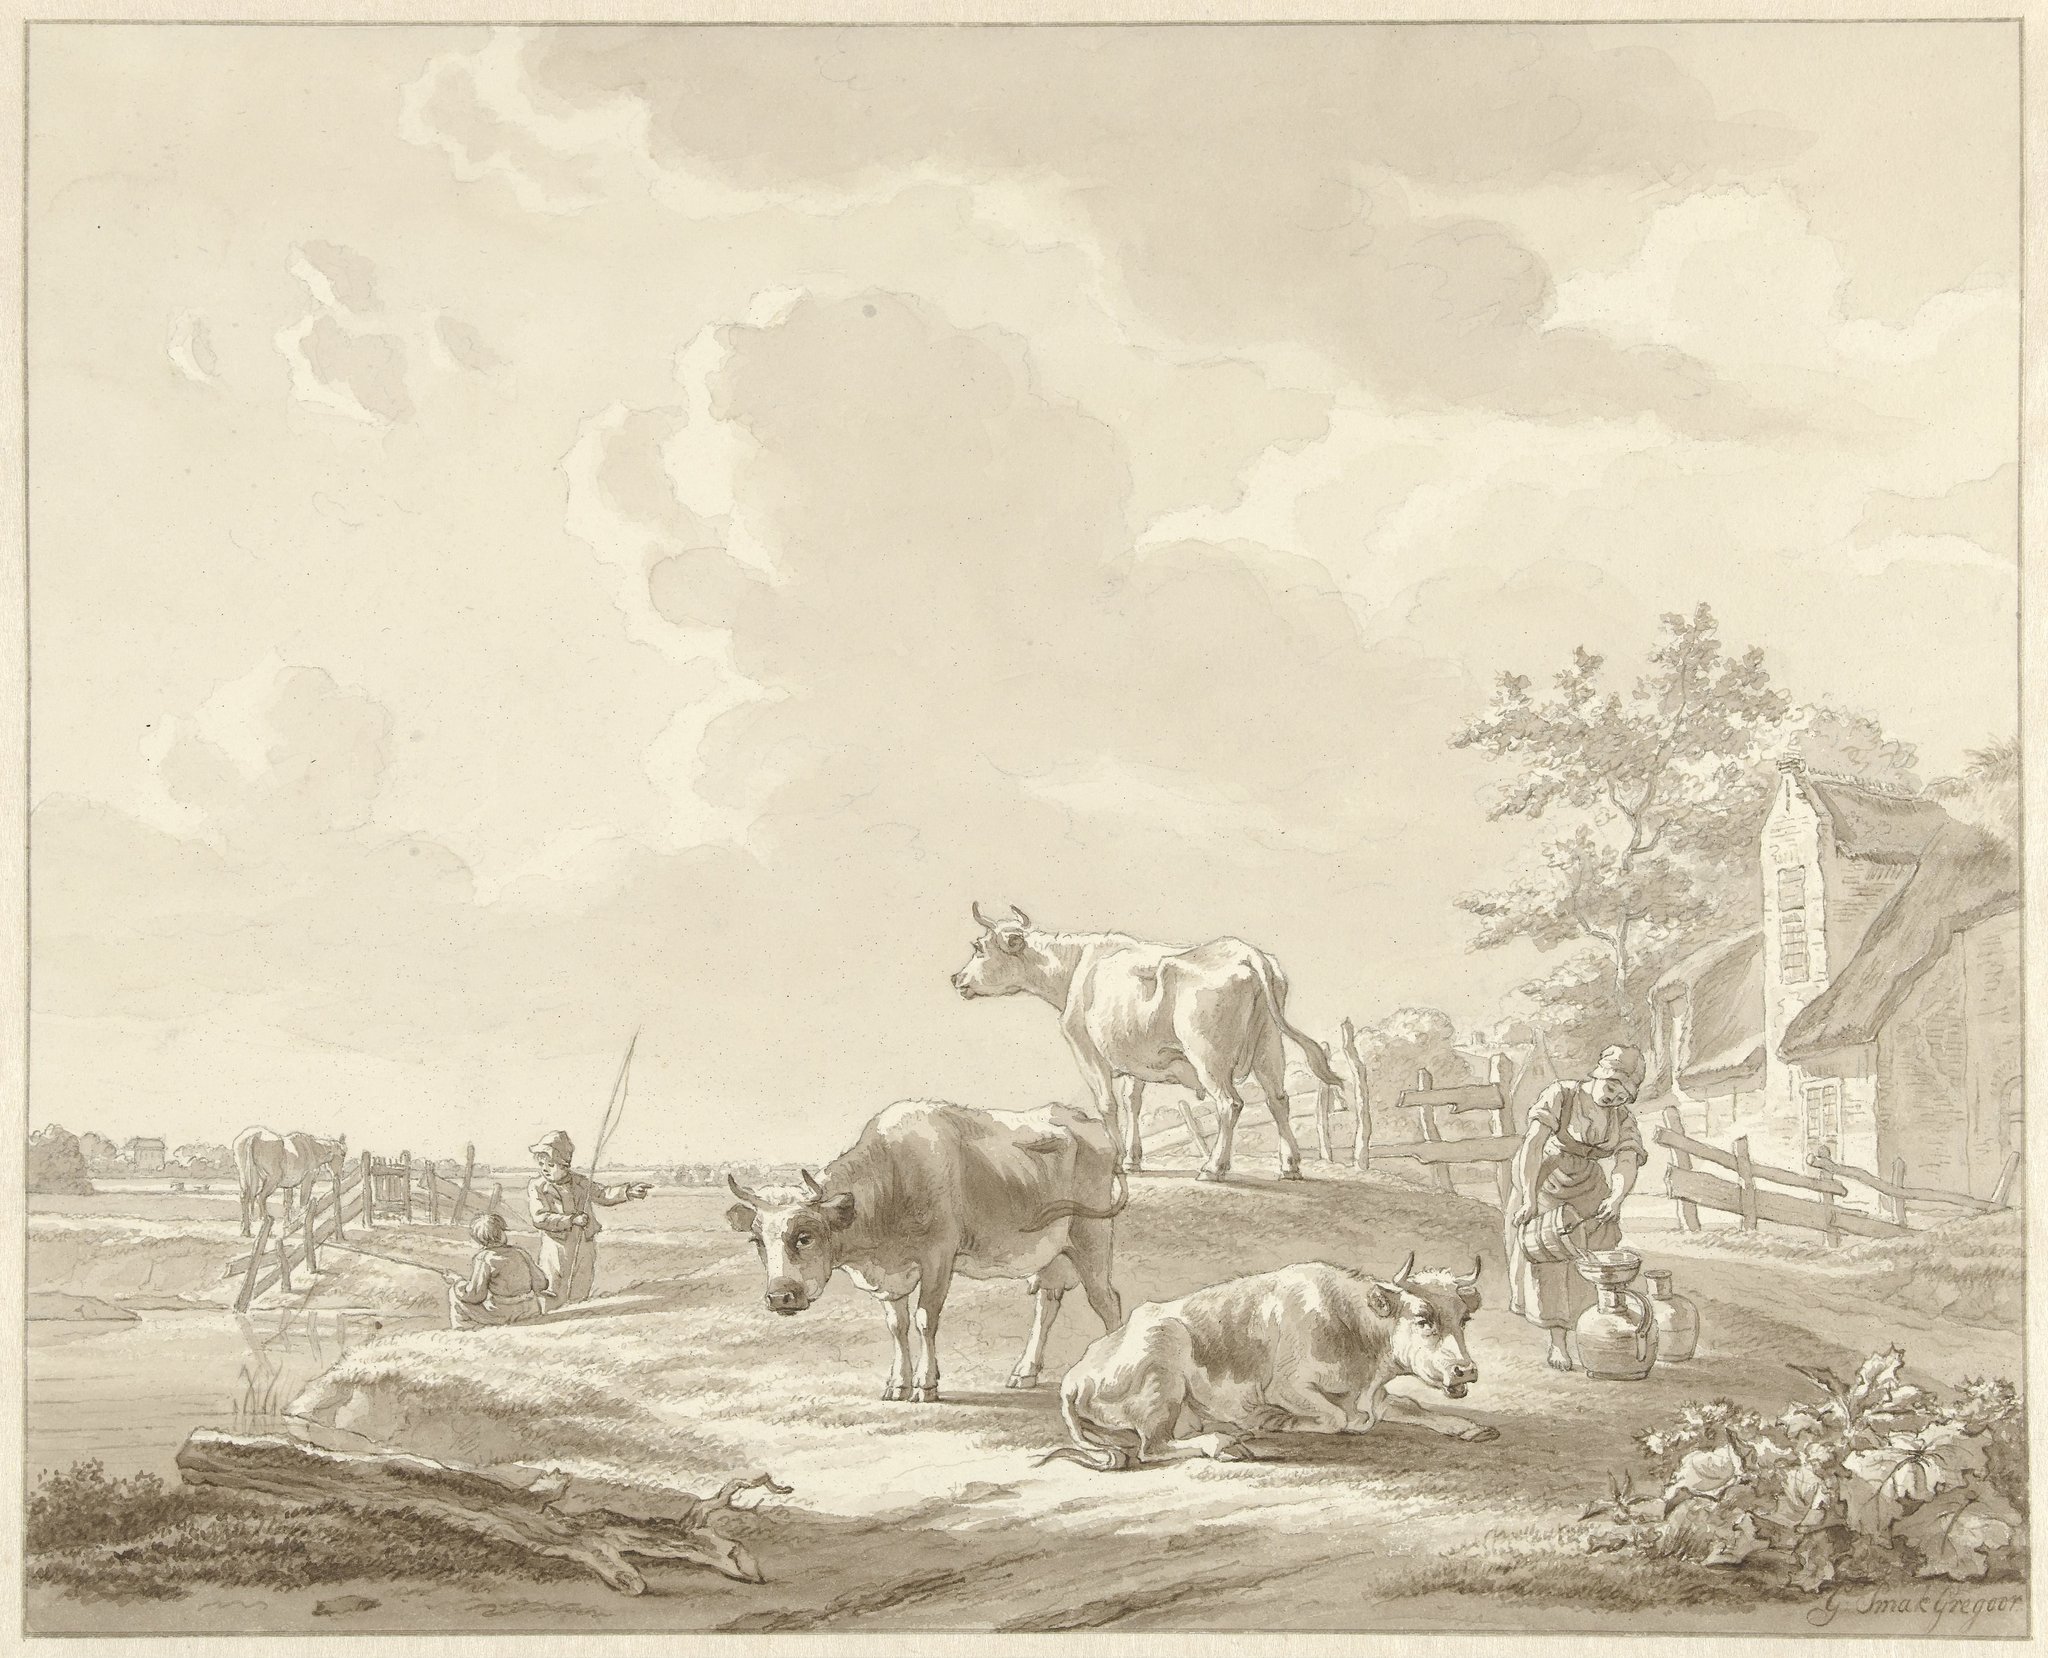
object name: drawing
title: Drie koeien bij een boerderij, twee vissende jongens en een vrouw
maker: gillis smak gregoor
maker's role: draughtsman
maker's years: 1770-1843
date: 1780-1843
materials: chalk, ink, paper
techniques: brush, pen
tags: bovine cattle, farm or solitary house in landscape, milking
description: Drie koeien bij een boerderij; links twee vissende jongens, rechts een vrouw met melkemmer en melkbussen.